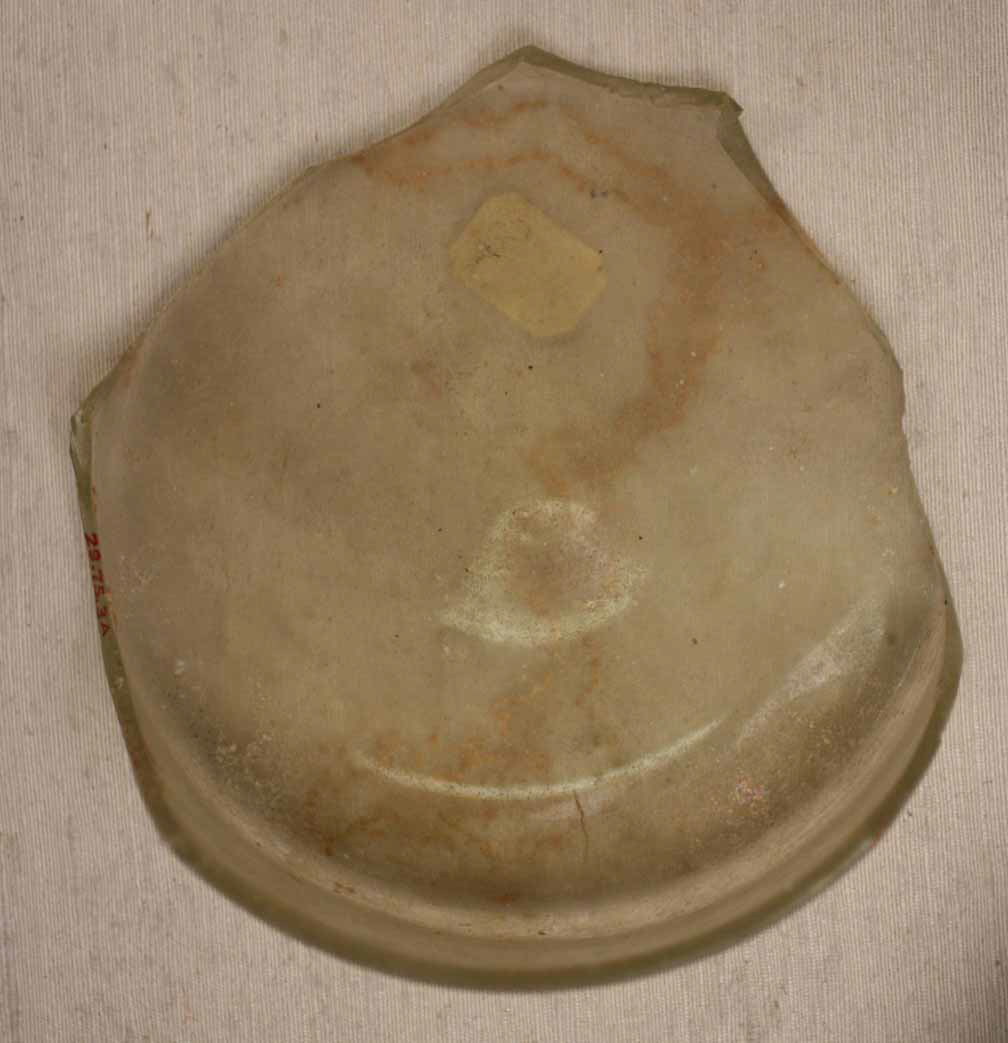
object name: fragment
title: Two Glass Fragments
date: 801-900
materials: glass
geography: iraq